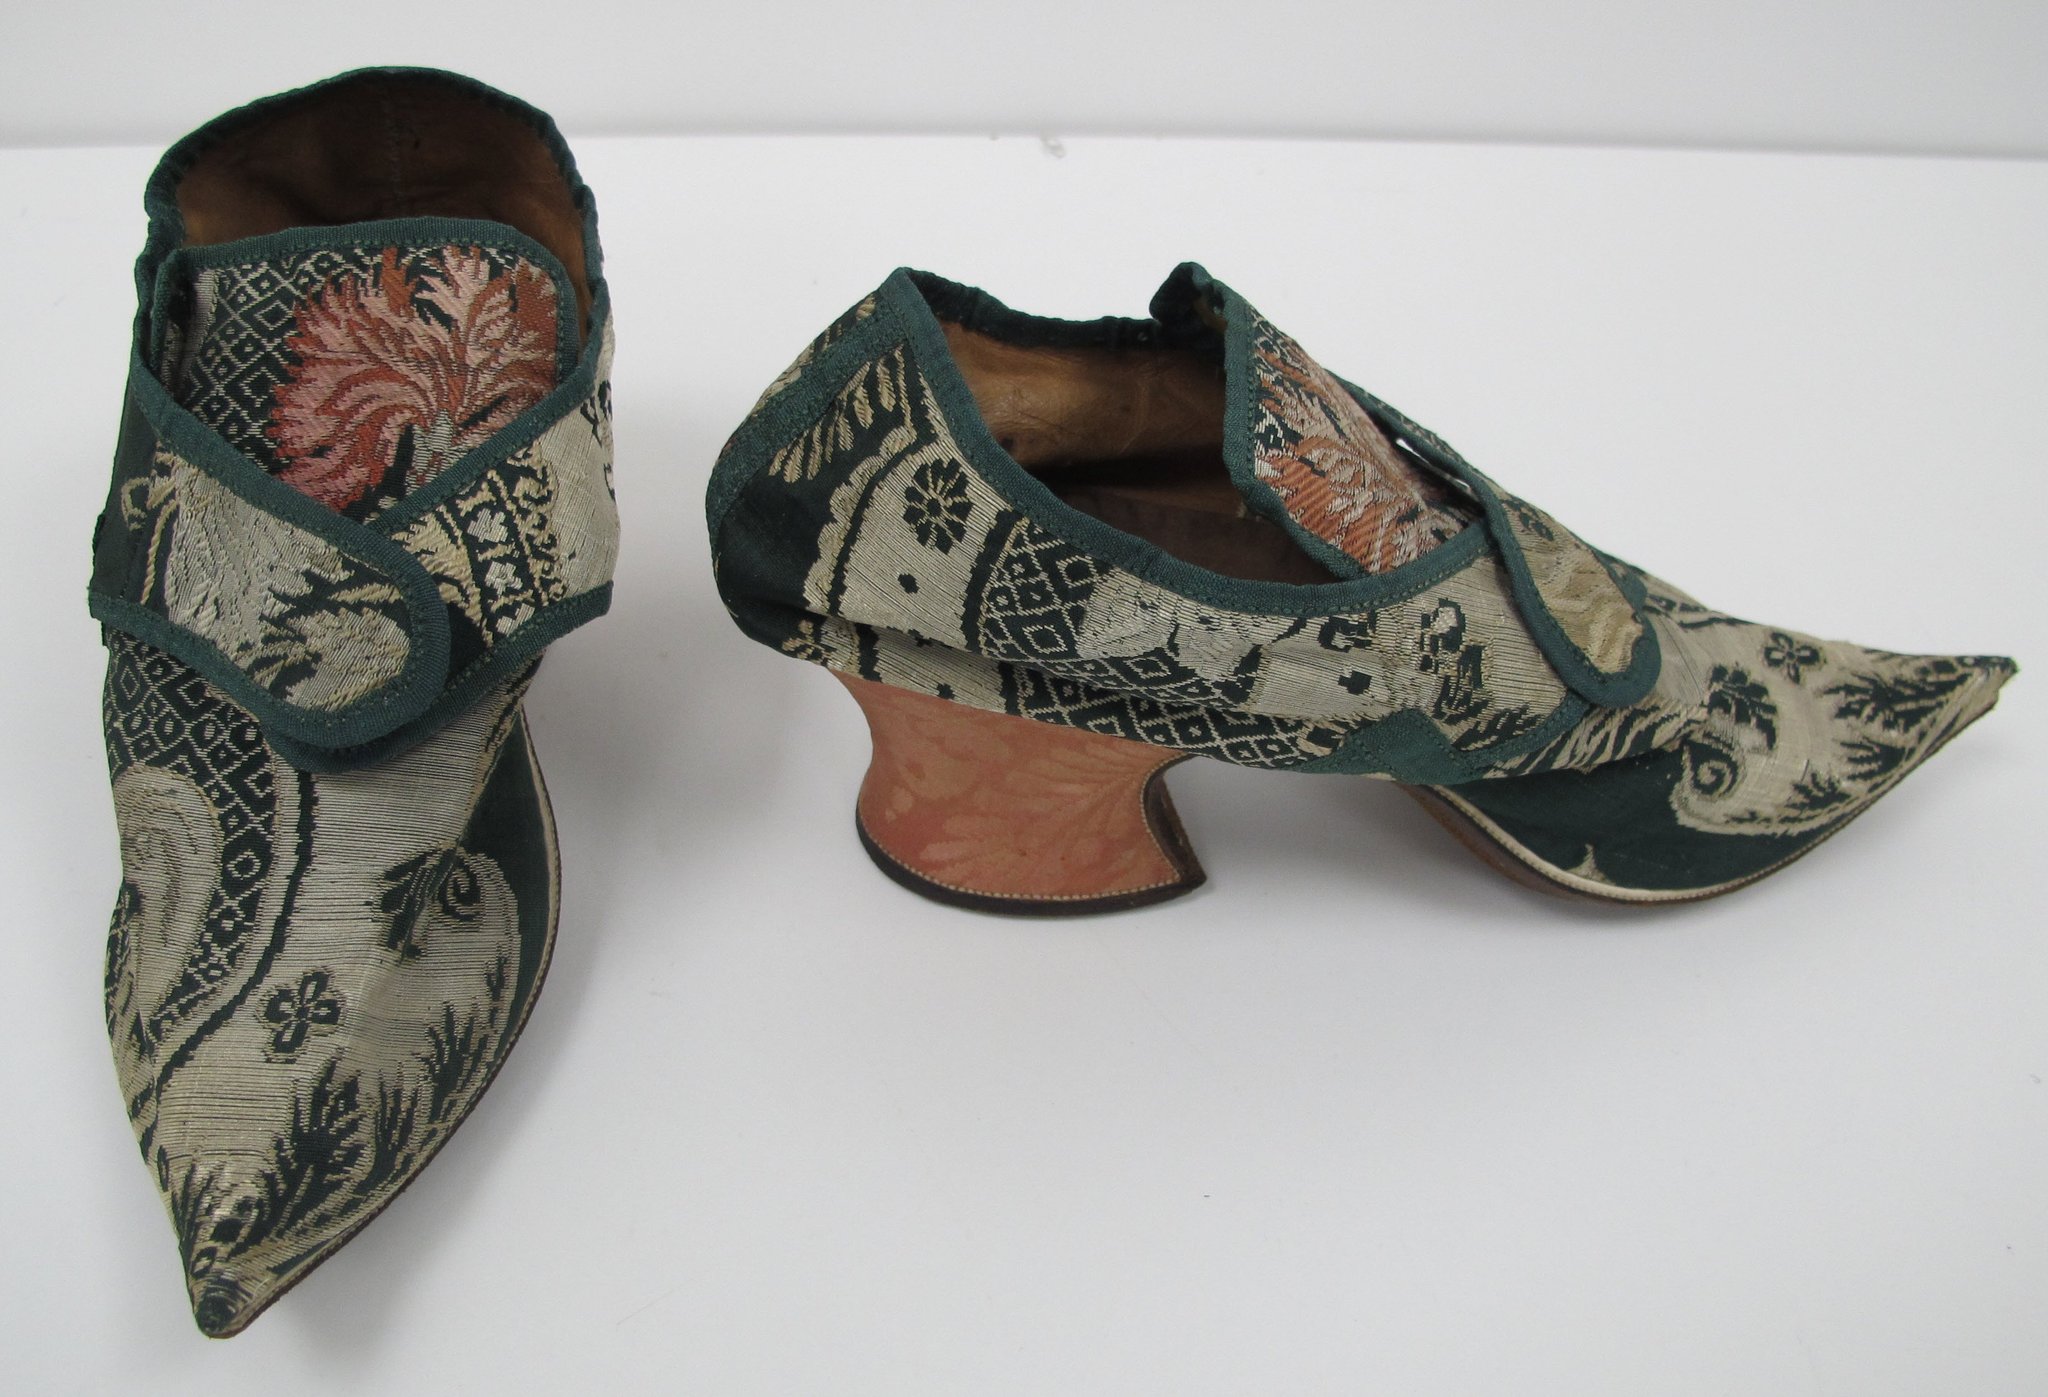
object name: shoe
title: Shoes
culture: british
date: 1721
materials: metal, silk